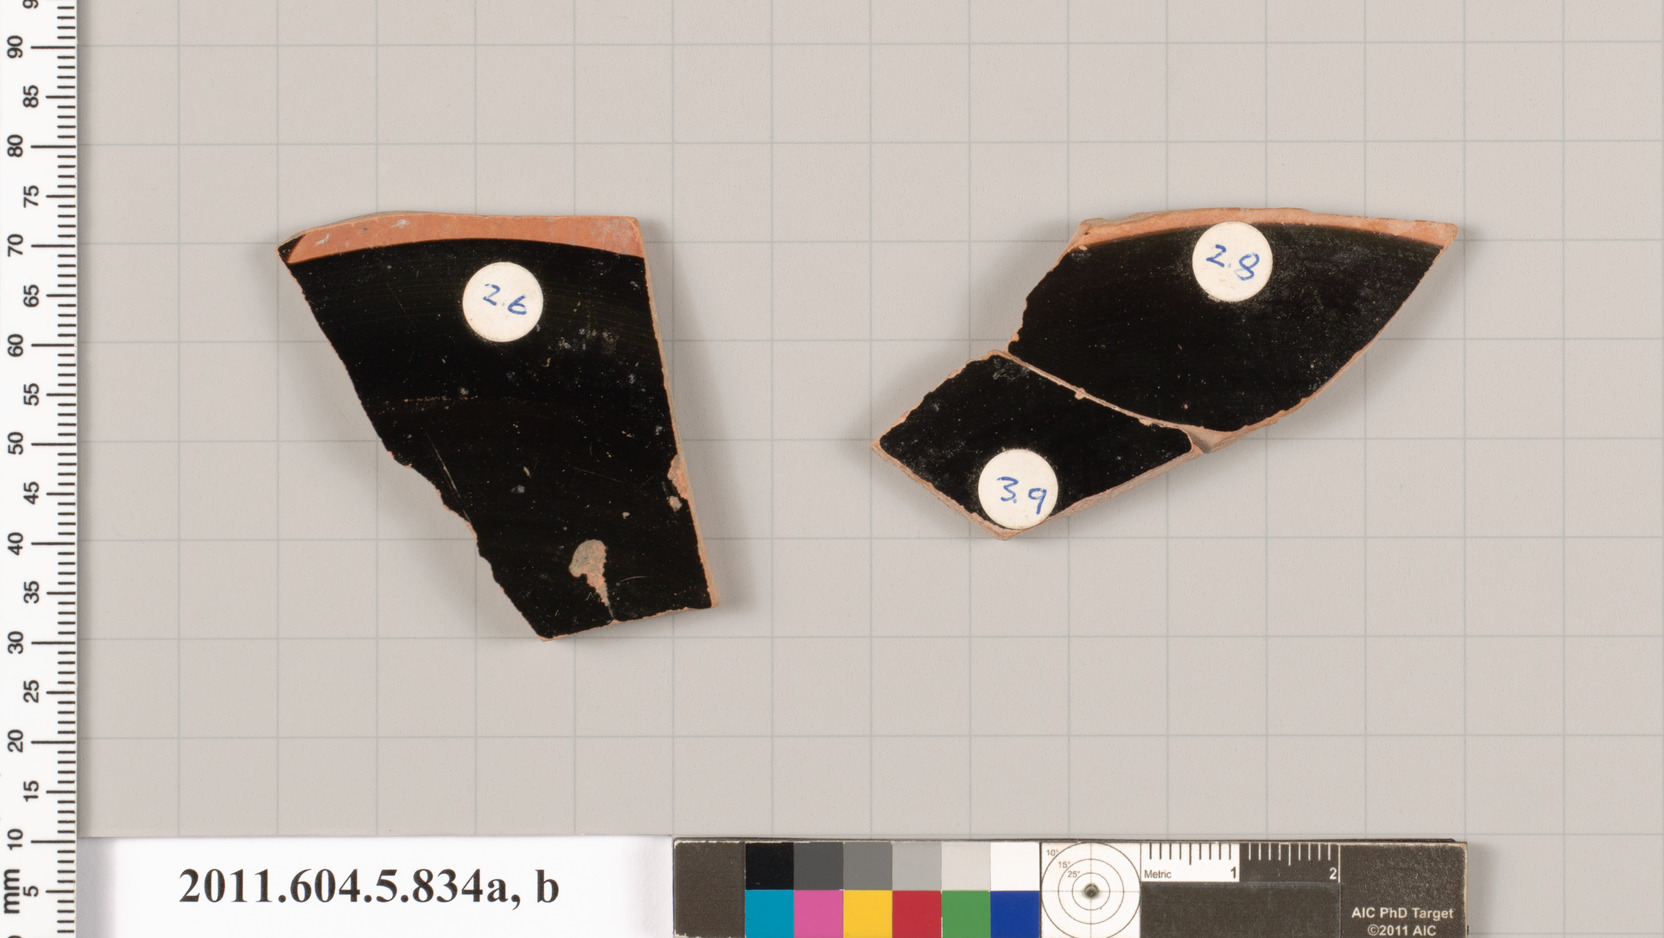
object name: kylix fragment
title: Terracotta fragments of kylikes (drinking cups)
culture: greek, attic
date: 600-401 BCE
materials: terracotta